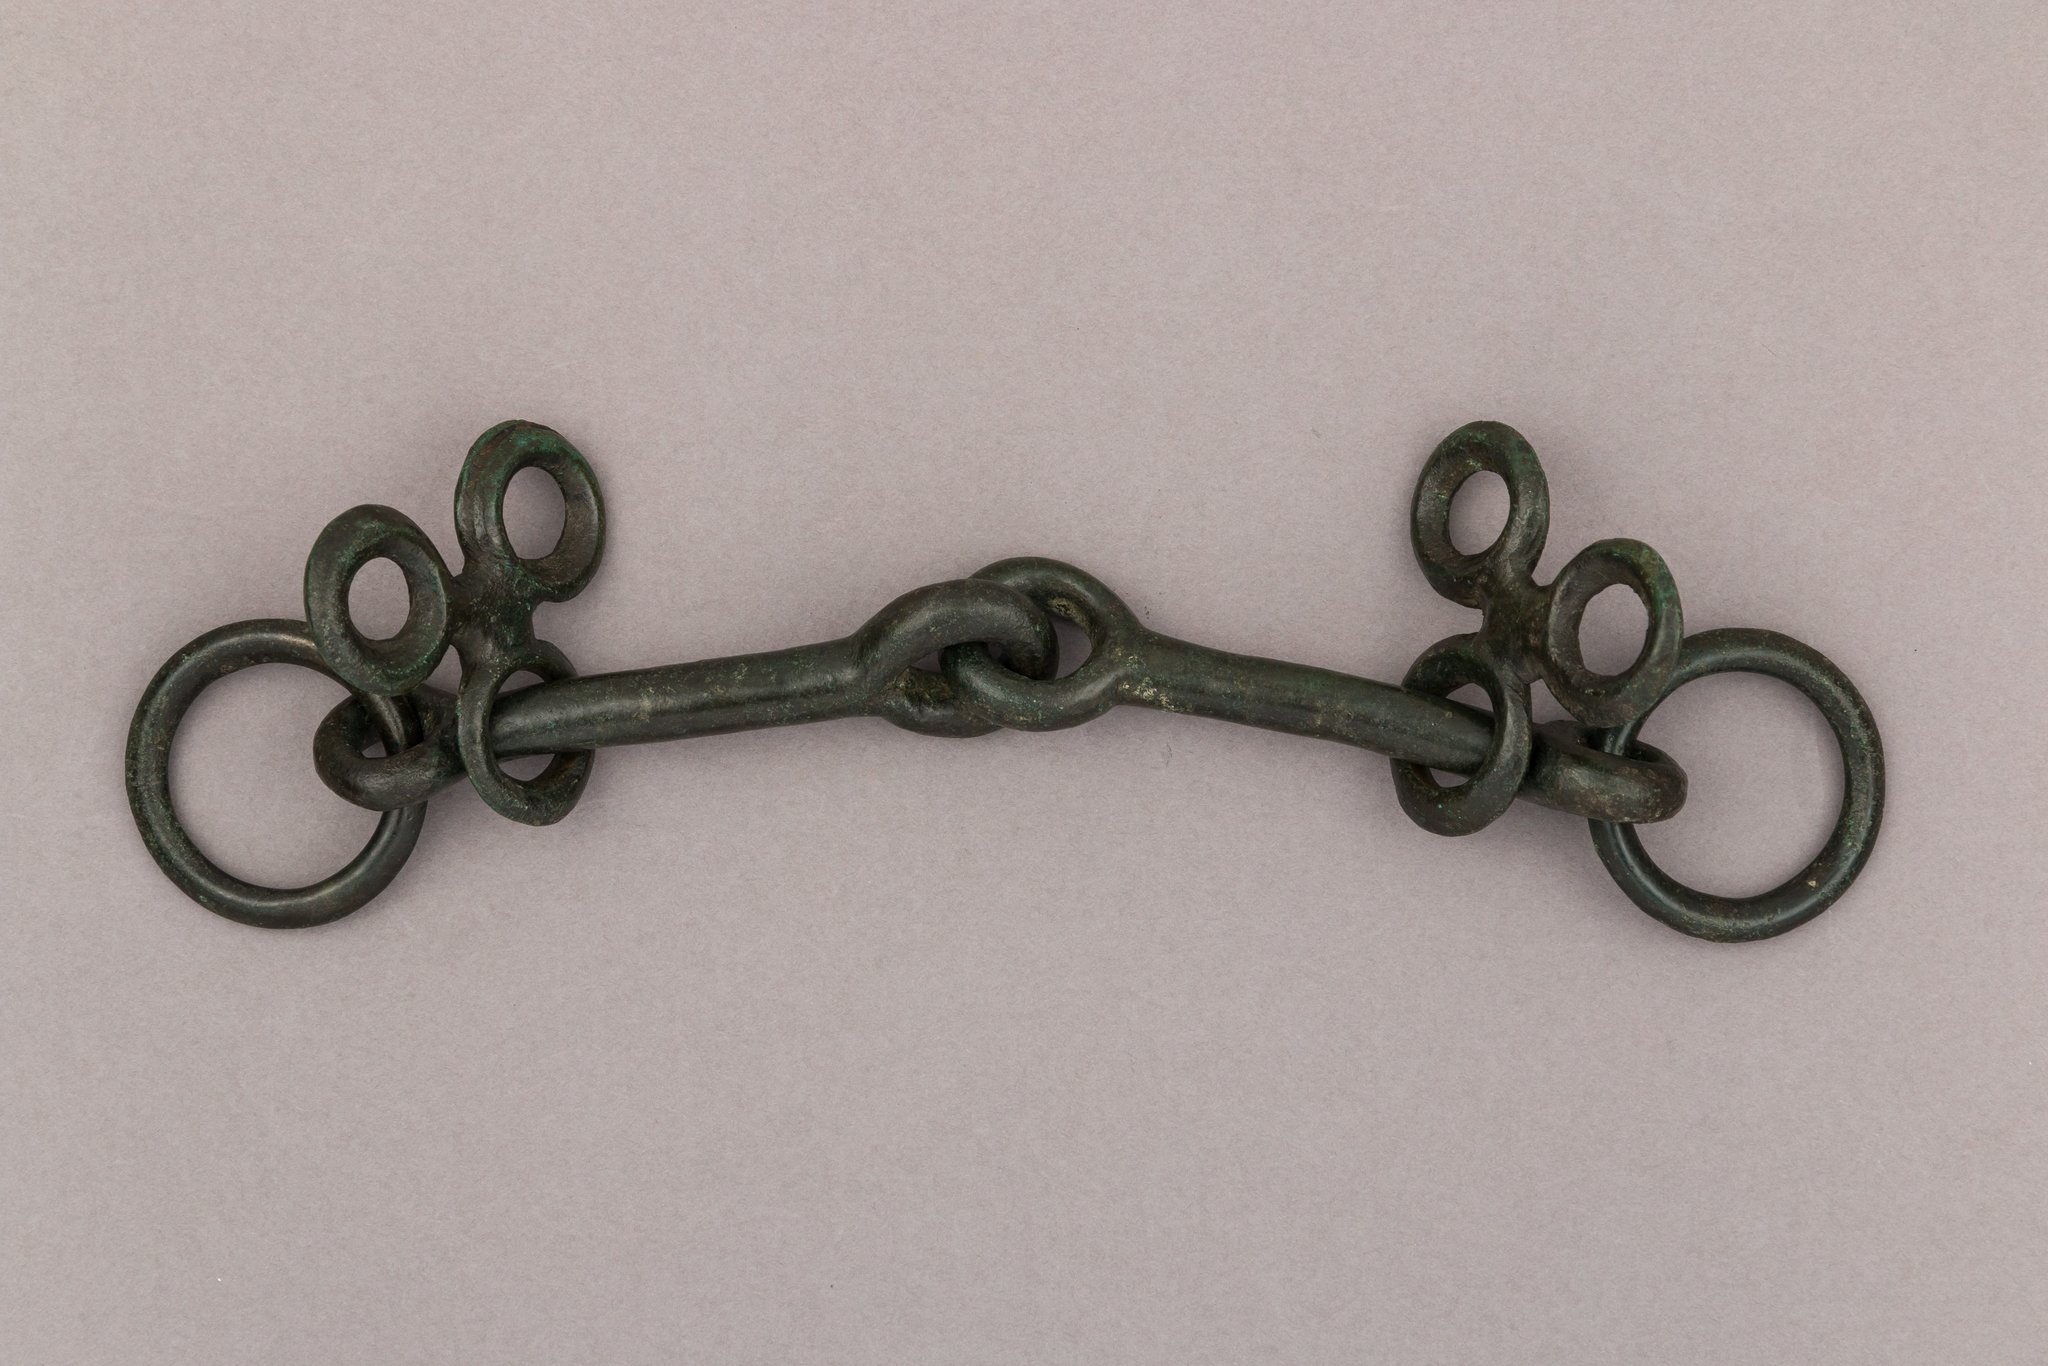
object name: bit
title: Snaffle Bit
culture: etruscan or villanovan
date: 800-601 BCE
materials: copper alloy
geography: italy